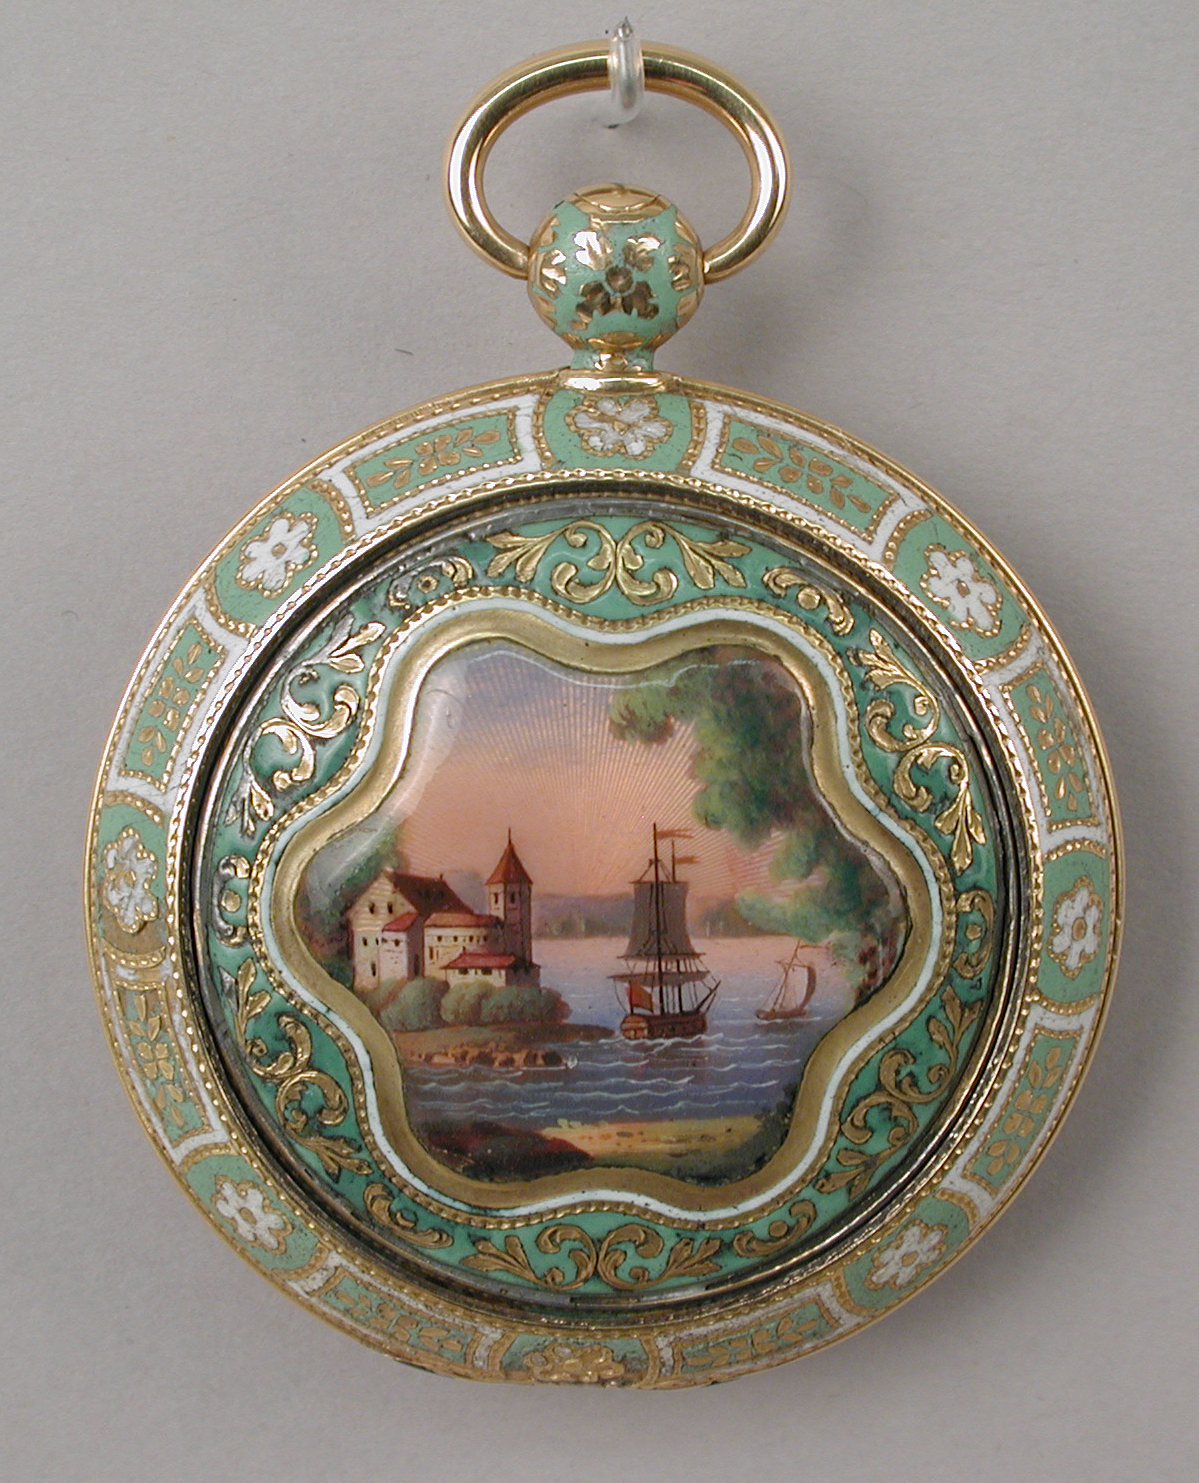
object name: watch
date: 1805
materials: enamel, metal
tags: houses,boats